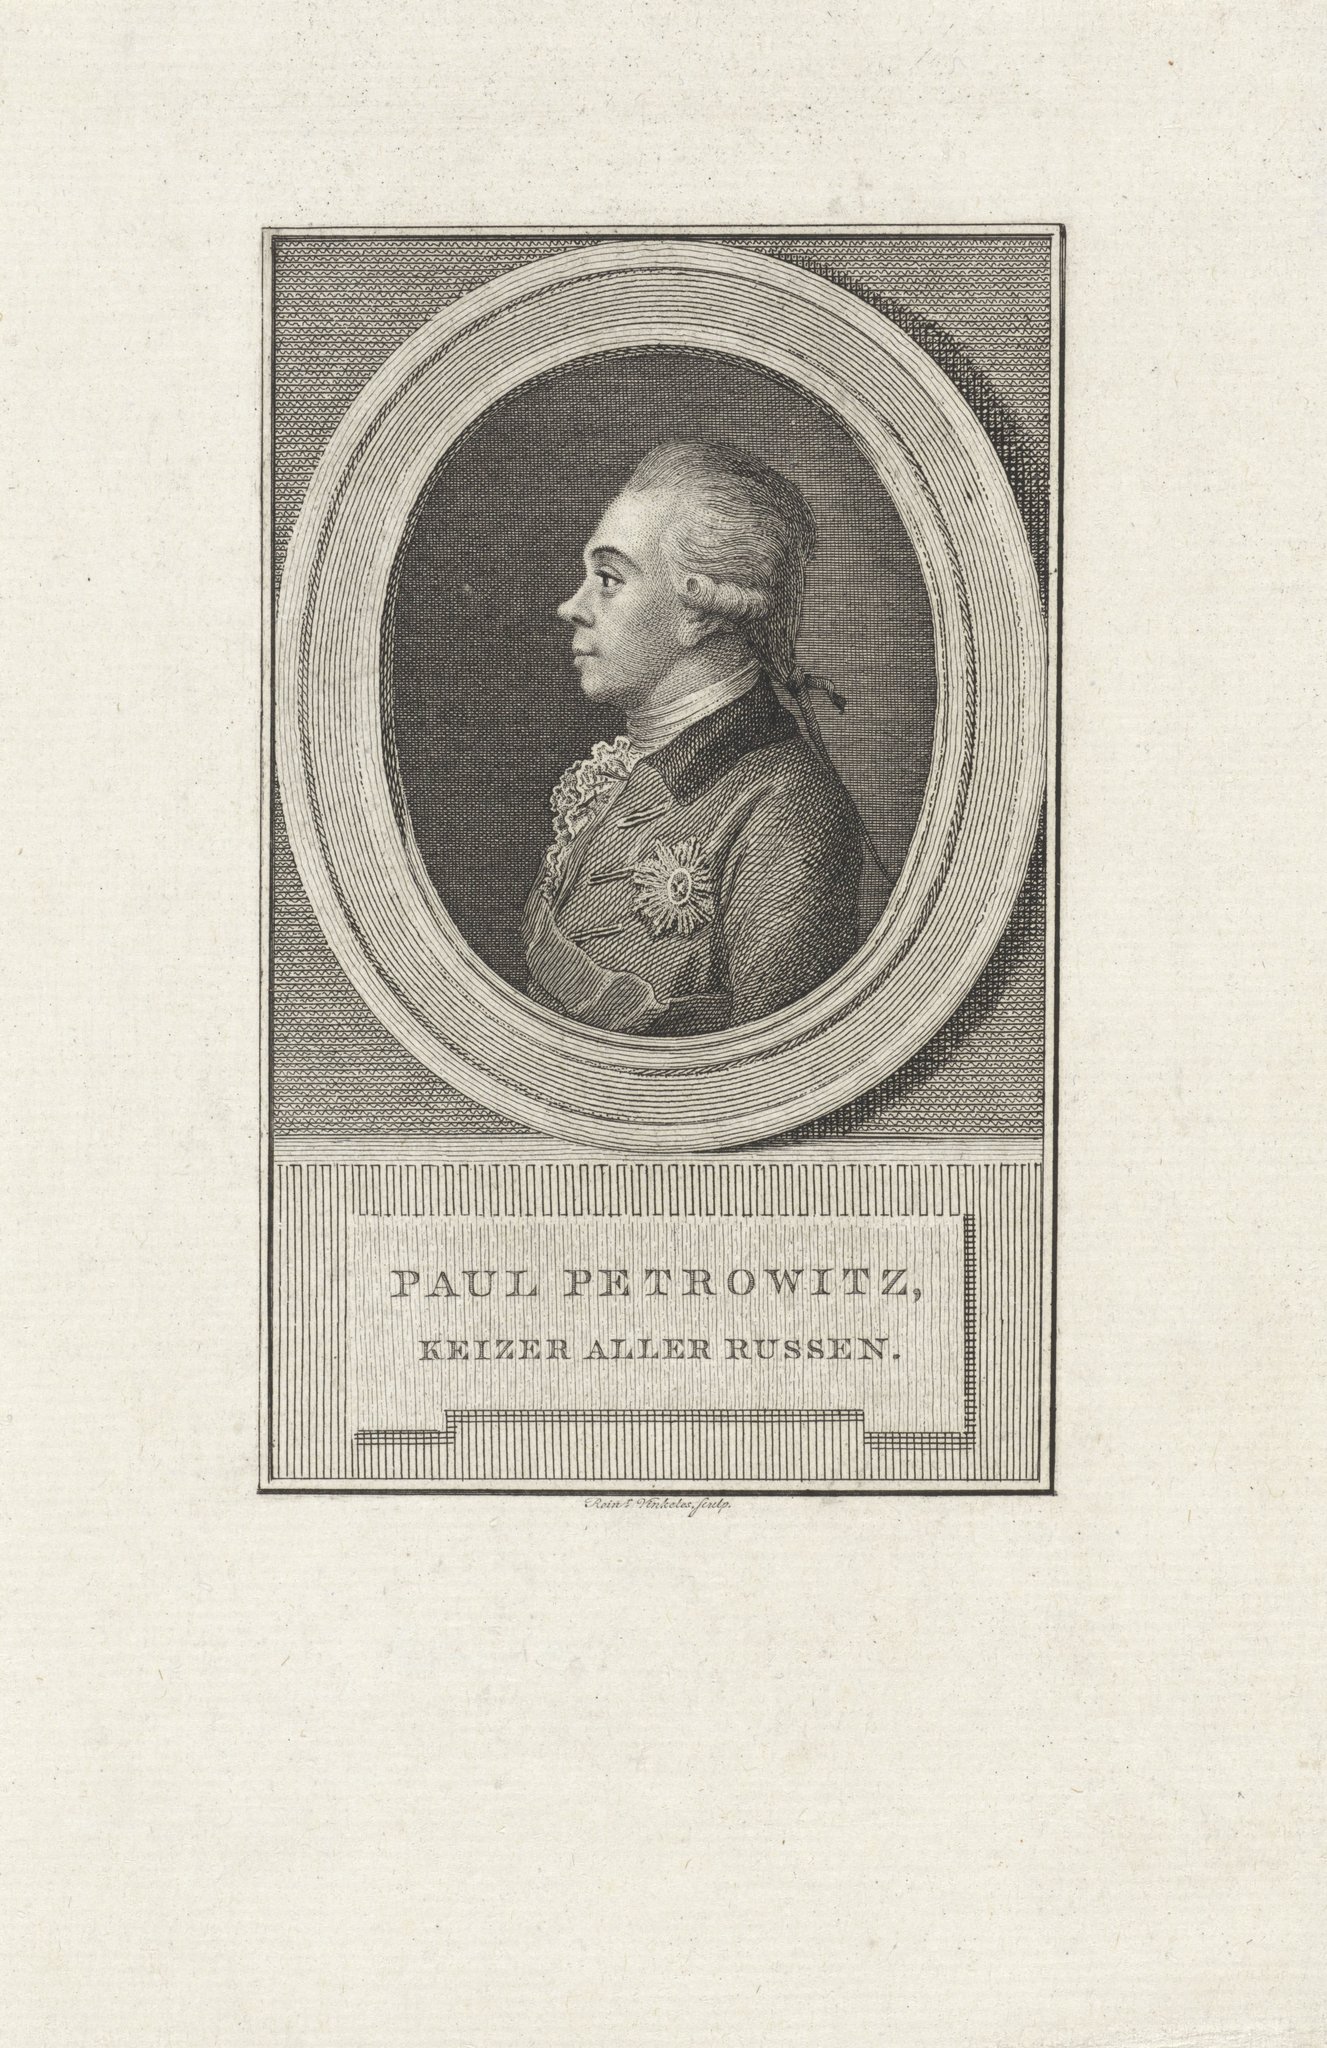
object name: print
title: Portret van Paul I, tsaar van Rusland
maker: reinier vinkeles (i)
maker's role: draughtsman, print maker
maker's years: 1741-1816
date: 1796-1816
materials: paper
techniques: etching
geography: amsterdam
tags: paul i (tsaar van rusland)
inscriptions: collector's mark: Lugt 240